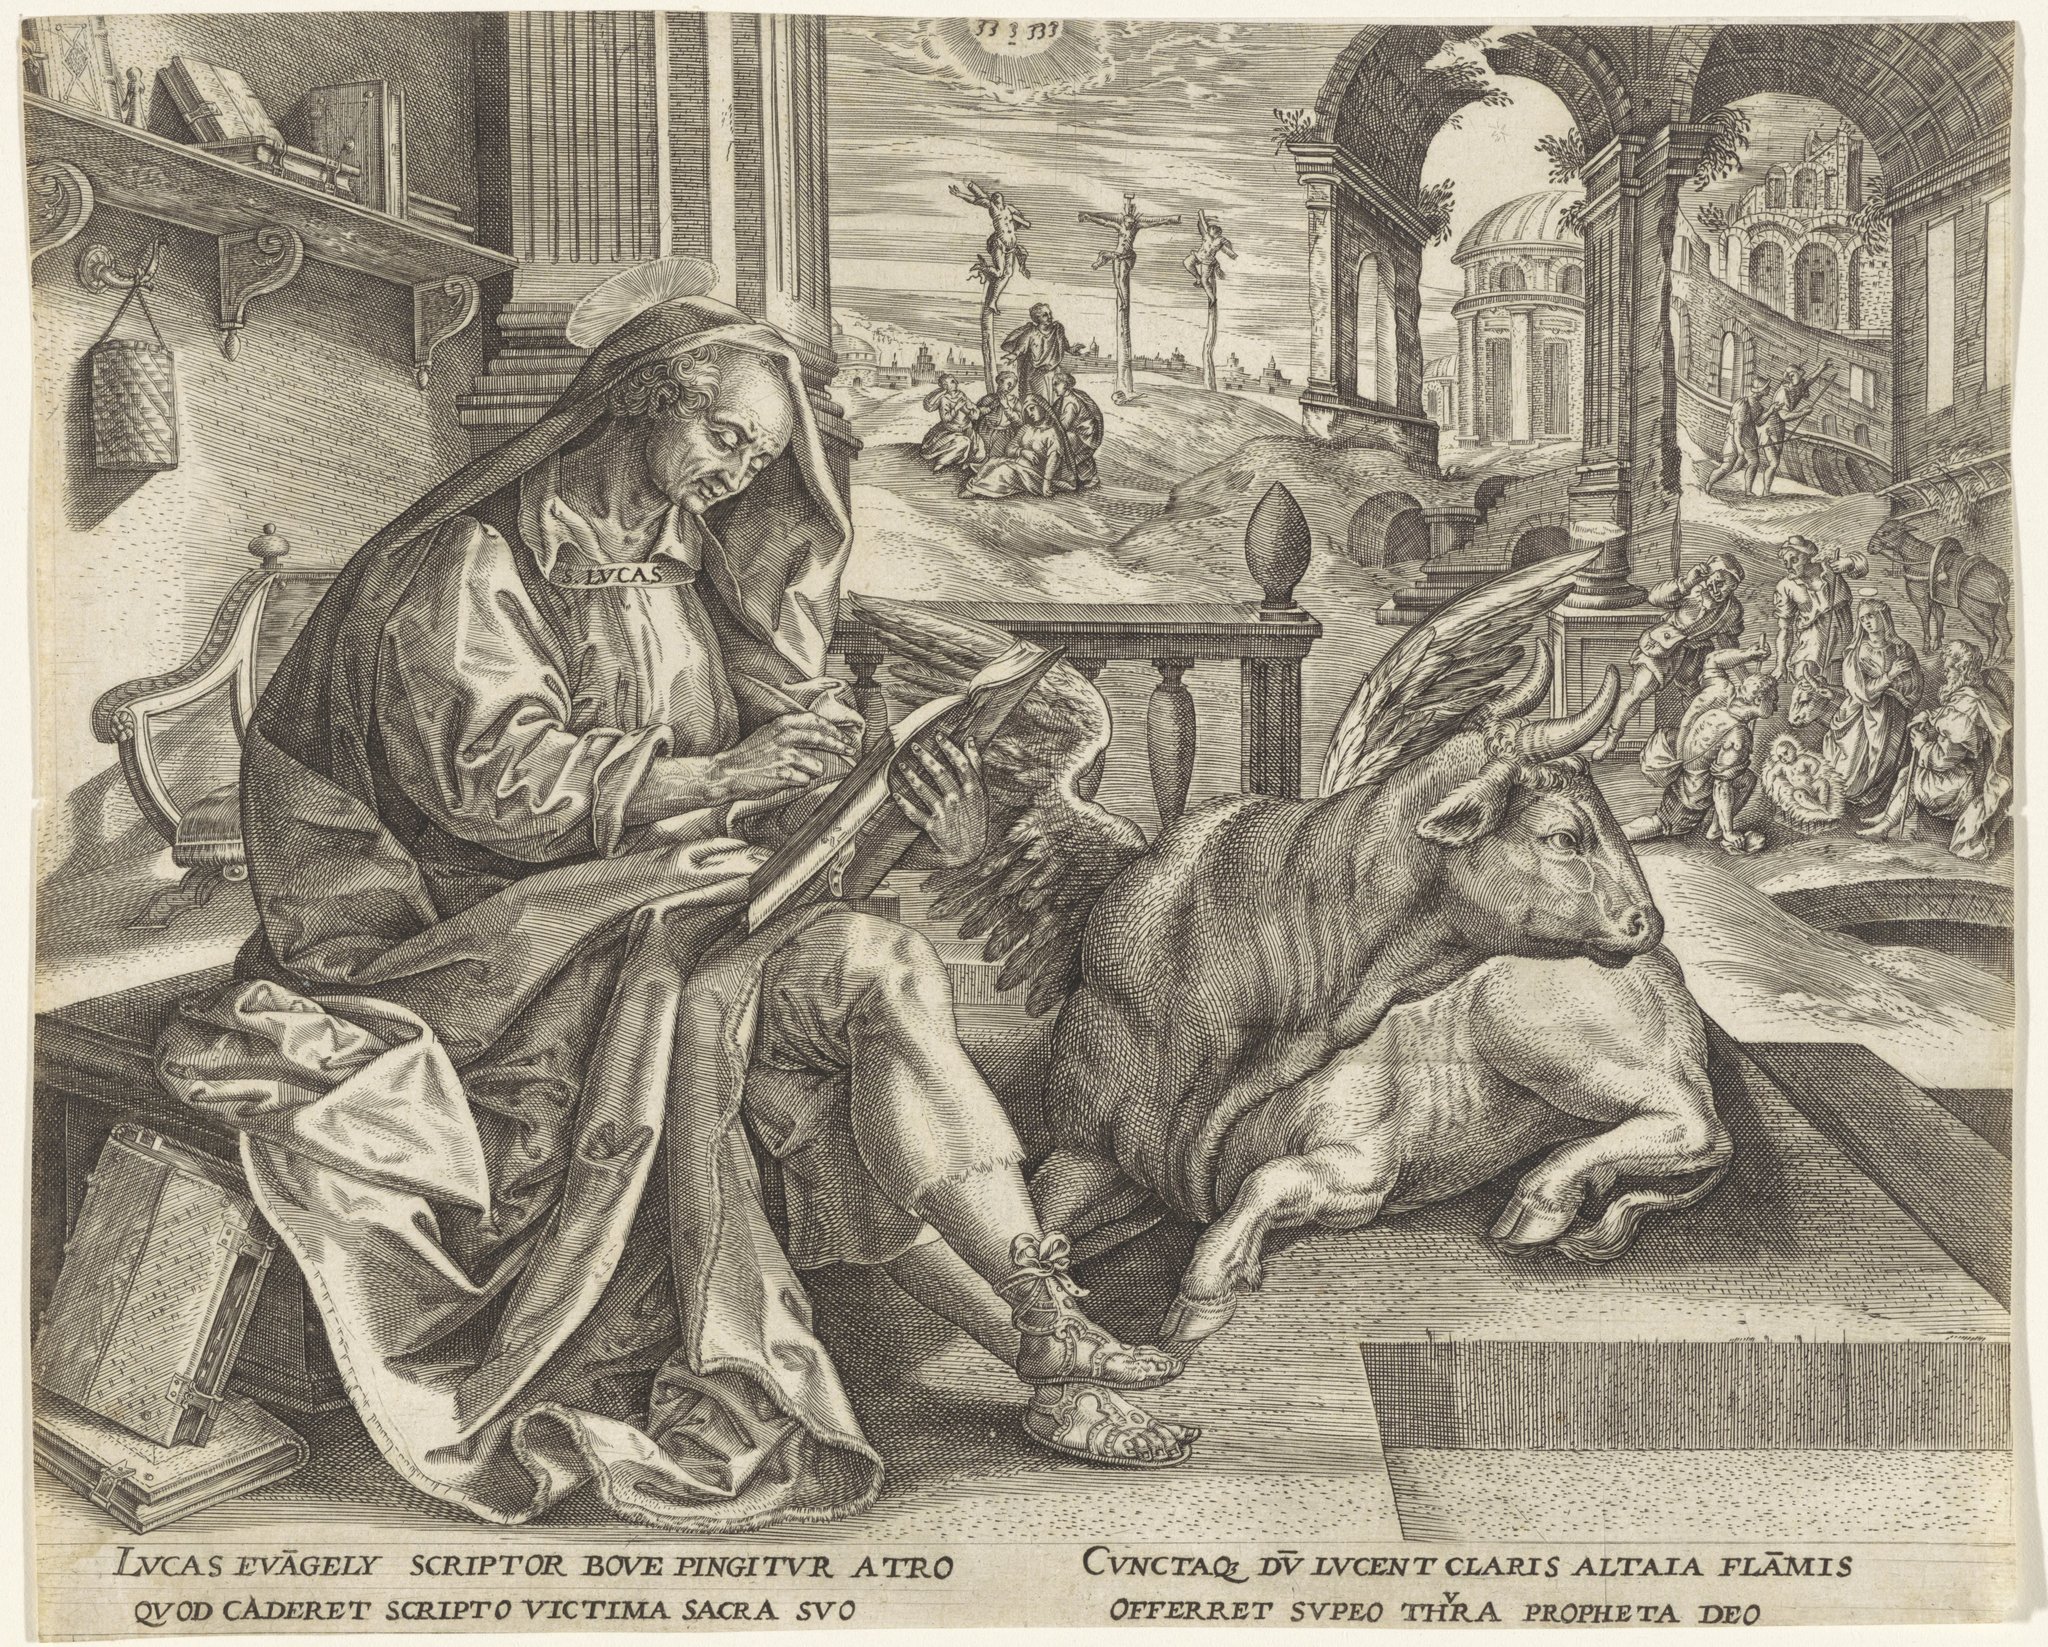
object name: print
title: Evangelist Lucas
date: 1559-1584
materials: paper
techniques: engraving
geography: antwerp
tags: crucified christ, with particular persons under the cross, adoration of the christ-child by the shepherds; mary and joseph present, st. luke writing his gospel, usually a (winged) ox present, tetragram (in roman or hebrew script) ~ symbol of god the father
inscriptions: collector's mark: Lugt 2228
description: De evangelist Lucas schrijft zijn evangelie. Naast hem de gevleugelde os. Op de achtergrond de kruisiging van Christus en de twee misdadigers. Maria en anderen treuren aan de voet van het kruis. Aan de rechterzijde de aanbidding van het Christuskind door de herders. In de marge een vierregelig onderschrift, in twee kolommen, in het Latijn.